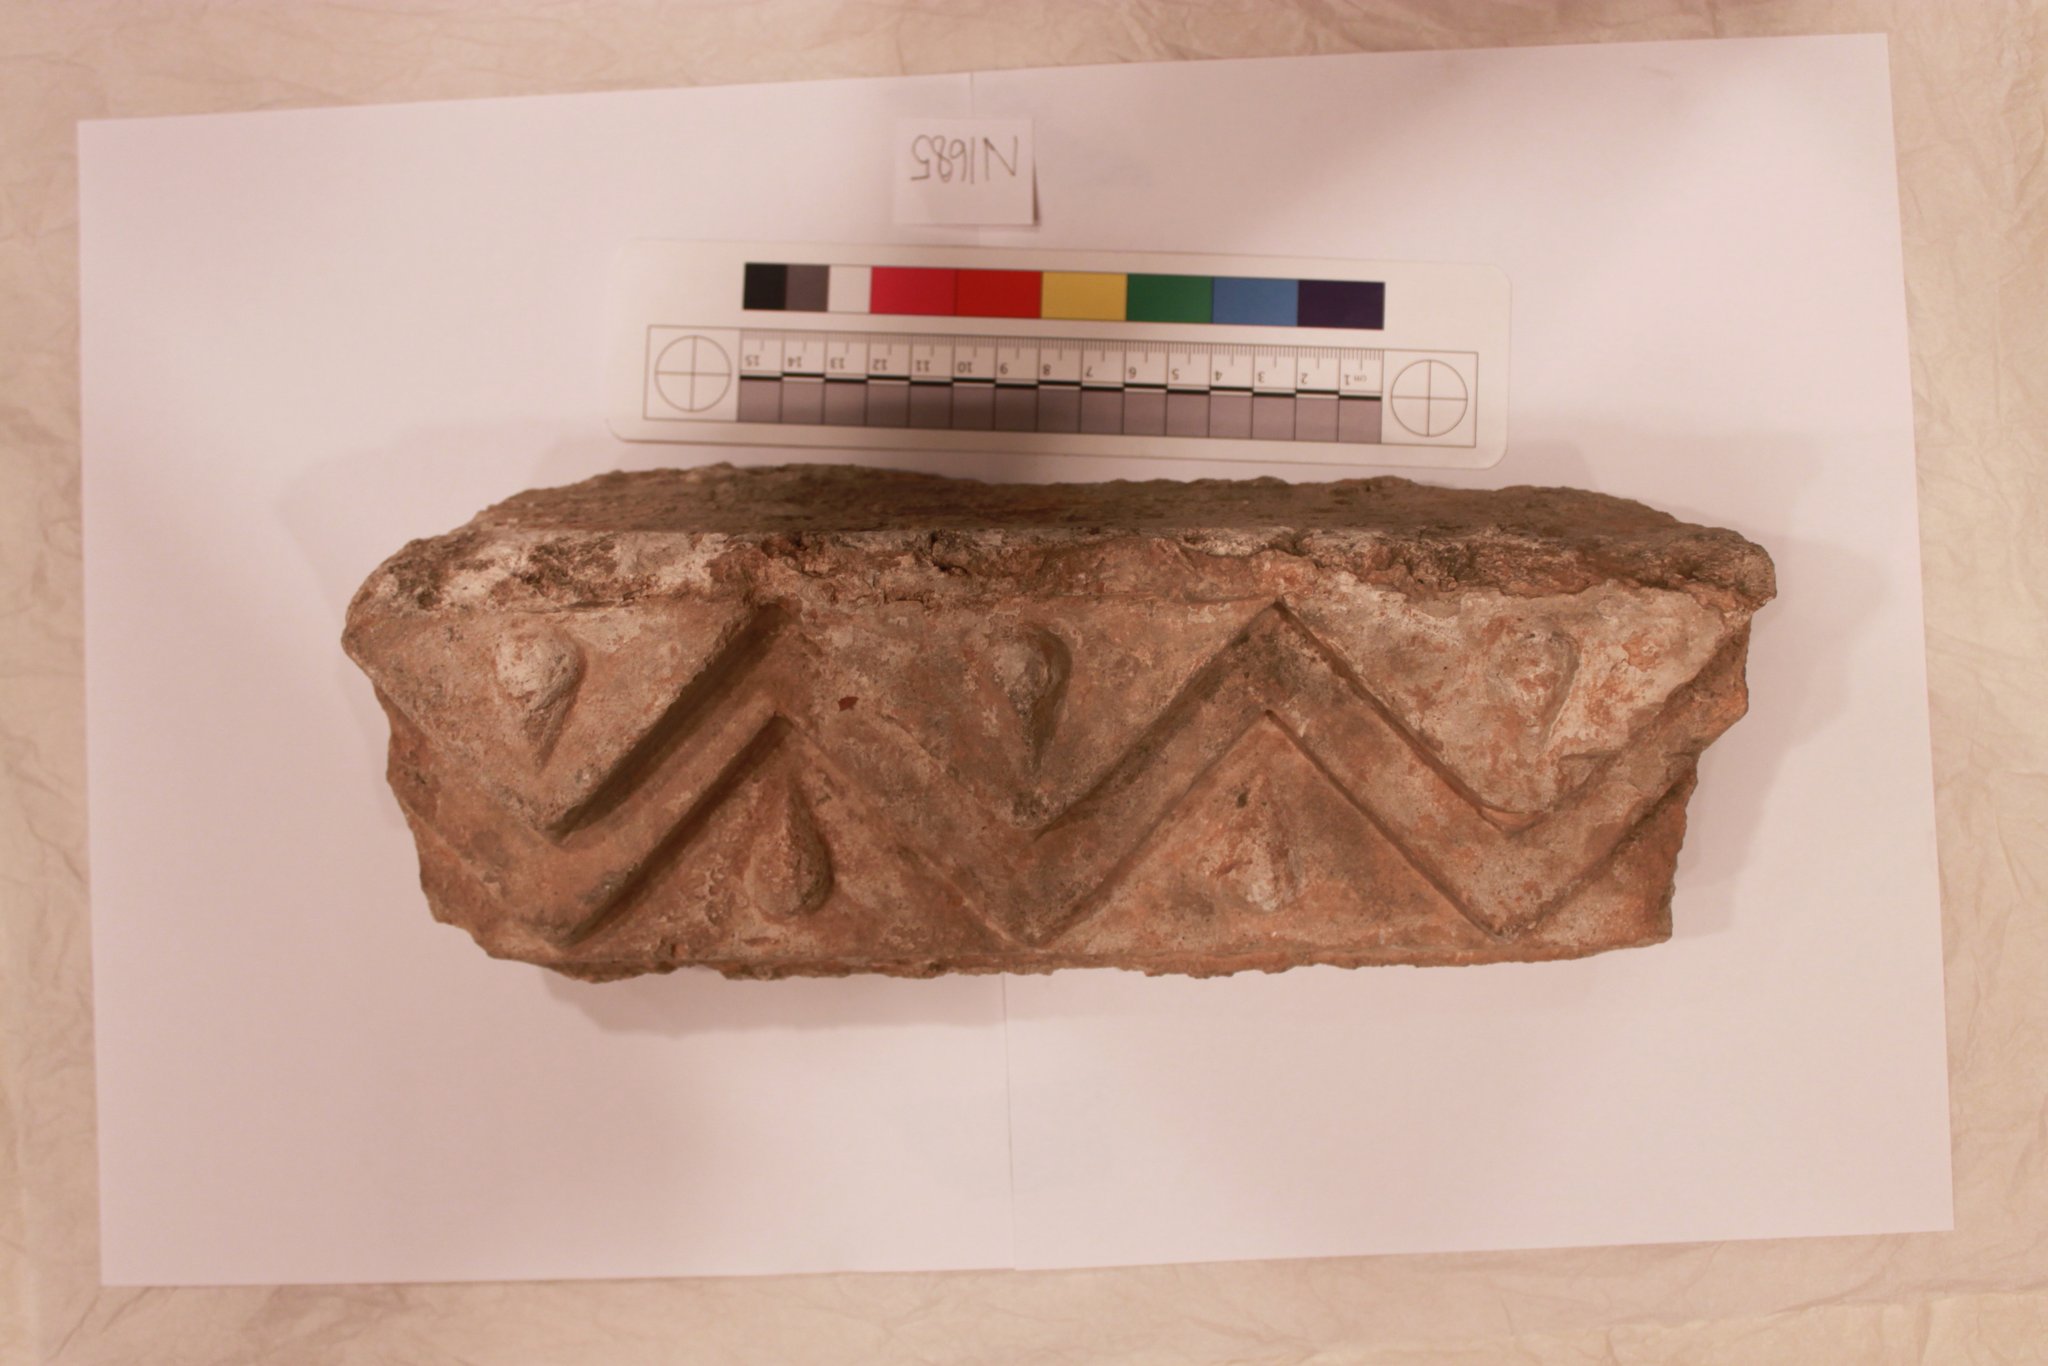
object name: fragment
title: Stucco Fragment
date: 701-1200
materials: plaster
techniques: carving, painting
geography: iran